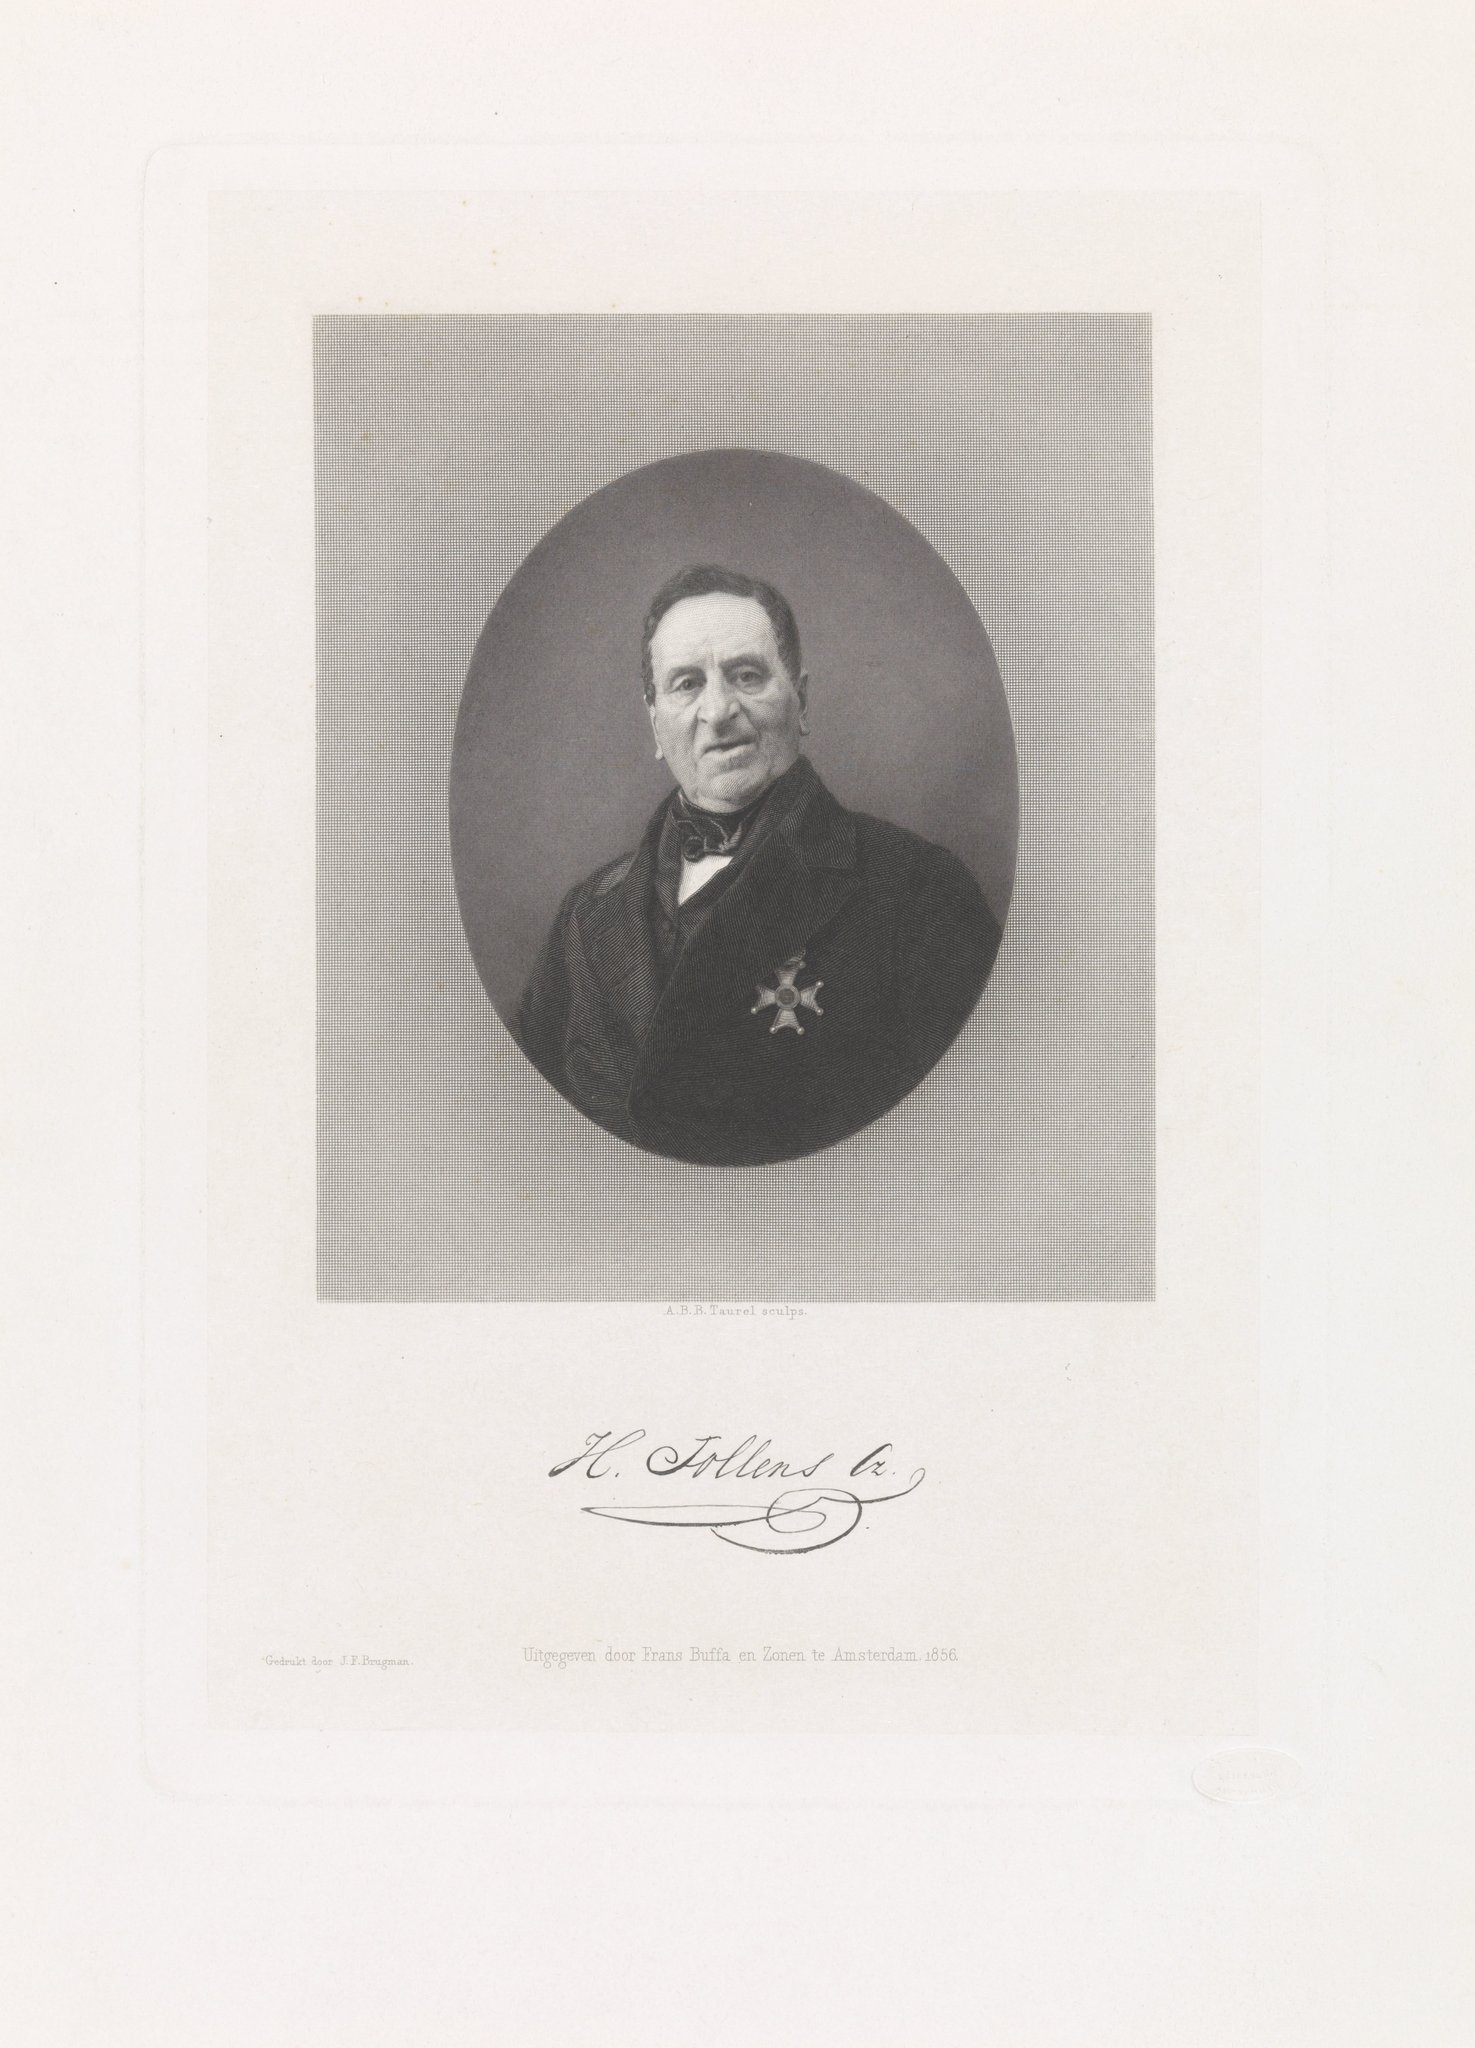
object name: print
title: Portret van de Rotterdamse dichter en koopman Hendrik Tollens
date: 1856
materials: paper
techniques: engraving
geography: amsterdam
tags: hendrik tollens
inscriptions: collector's mark: Lugt 2228, check stamp: ‘Frans Buffa en Zonen uitgevers Amsterdam’